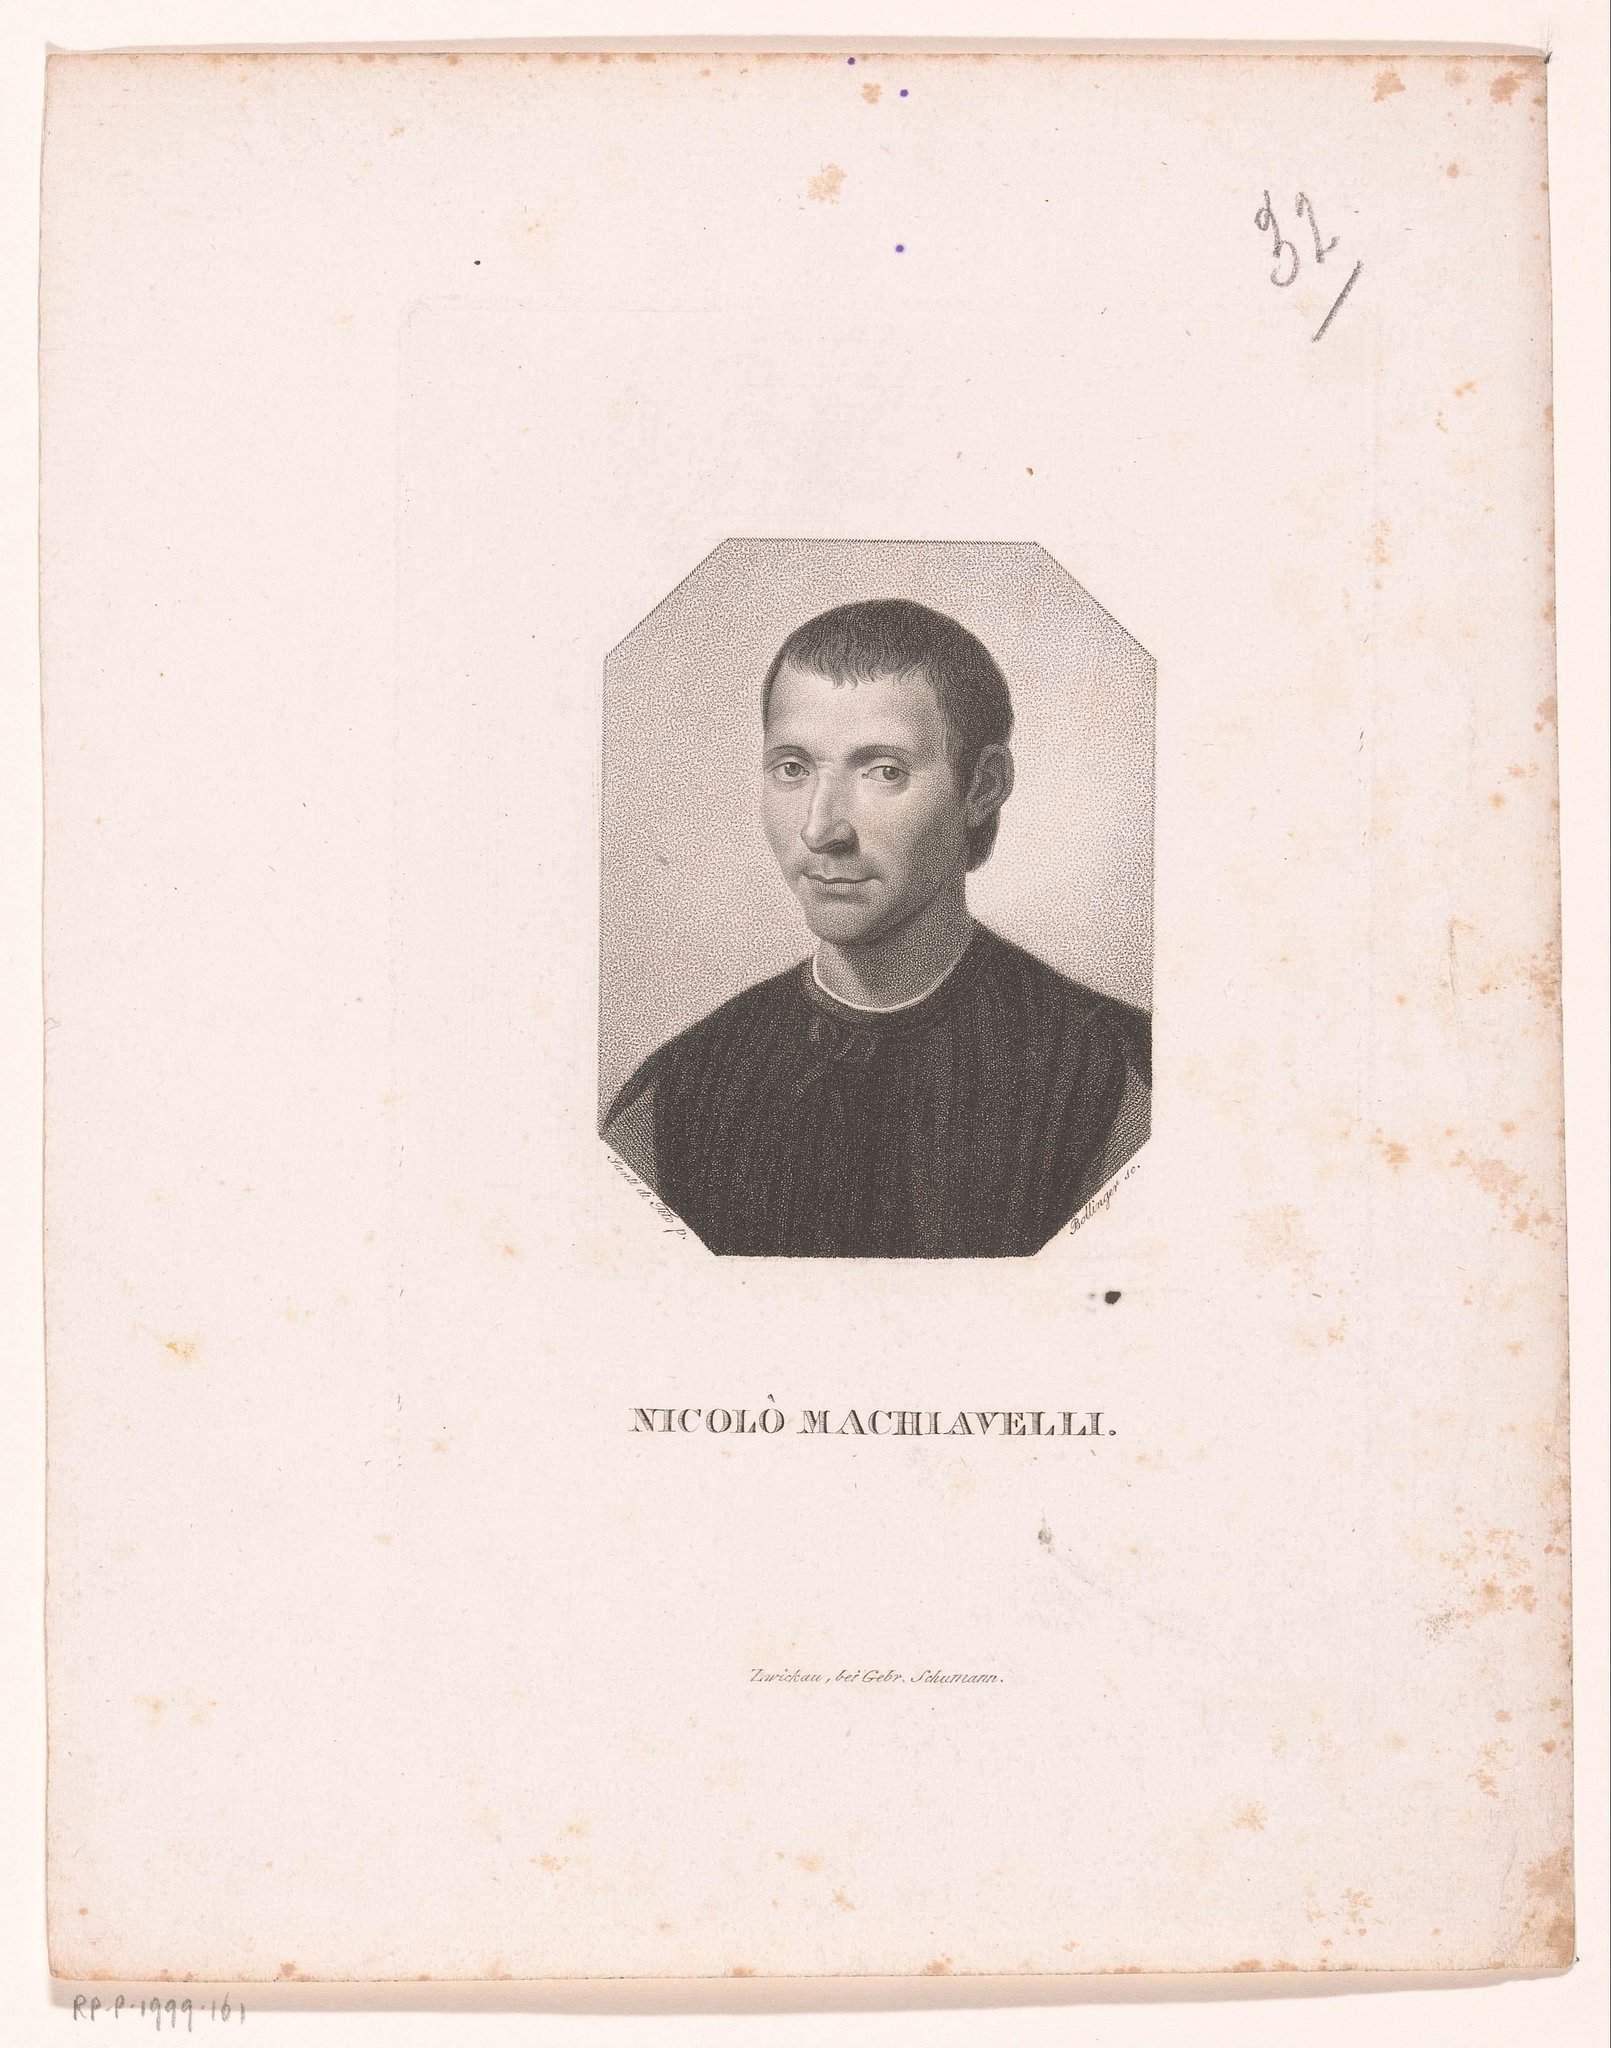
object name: print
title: Portretten van beroemde mensen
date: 1818-1832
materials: paper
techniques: stippling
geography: zwickau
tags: politician, historical persons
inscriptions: collector's mark: Lugt 2228, collector's mark: Lugt 2760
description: Prent gebruikt door de serie 'Bildnisse der berühmtesten Menschen aller Völker und Zeiten' van de gebroeders Schumann, uitgegeven in 1818-1832 te Zwickau.